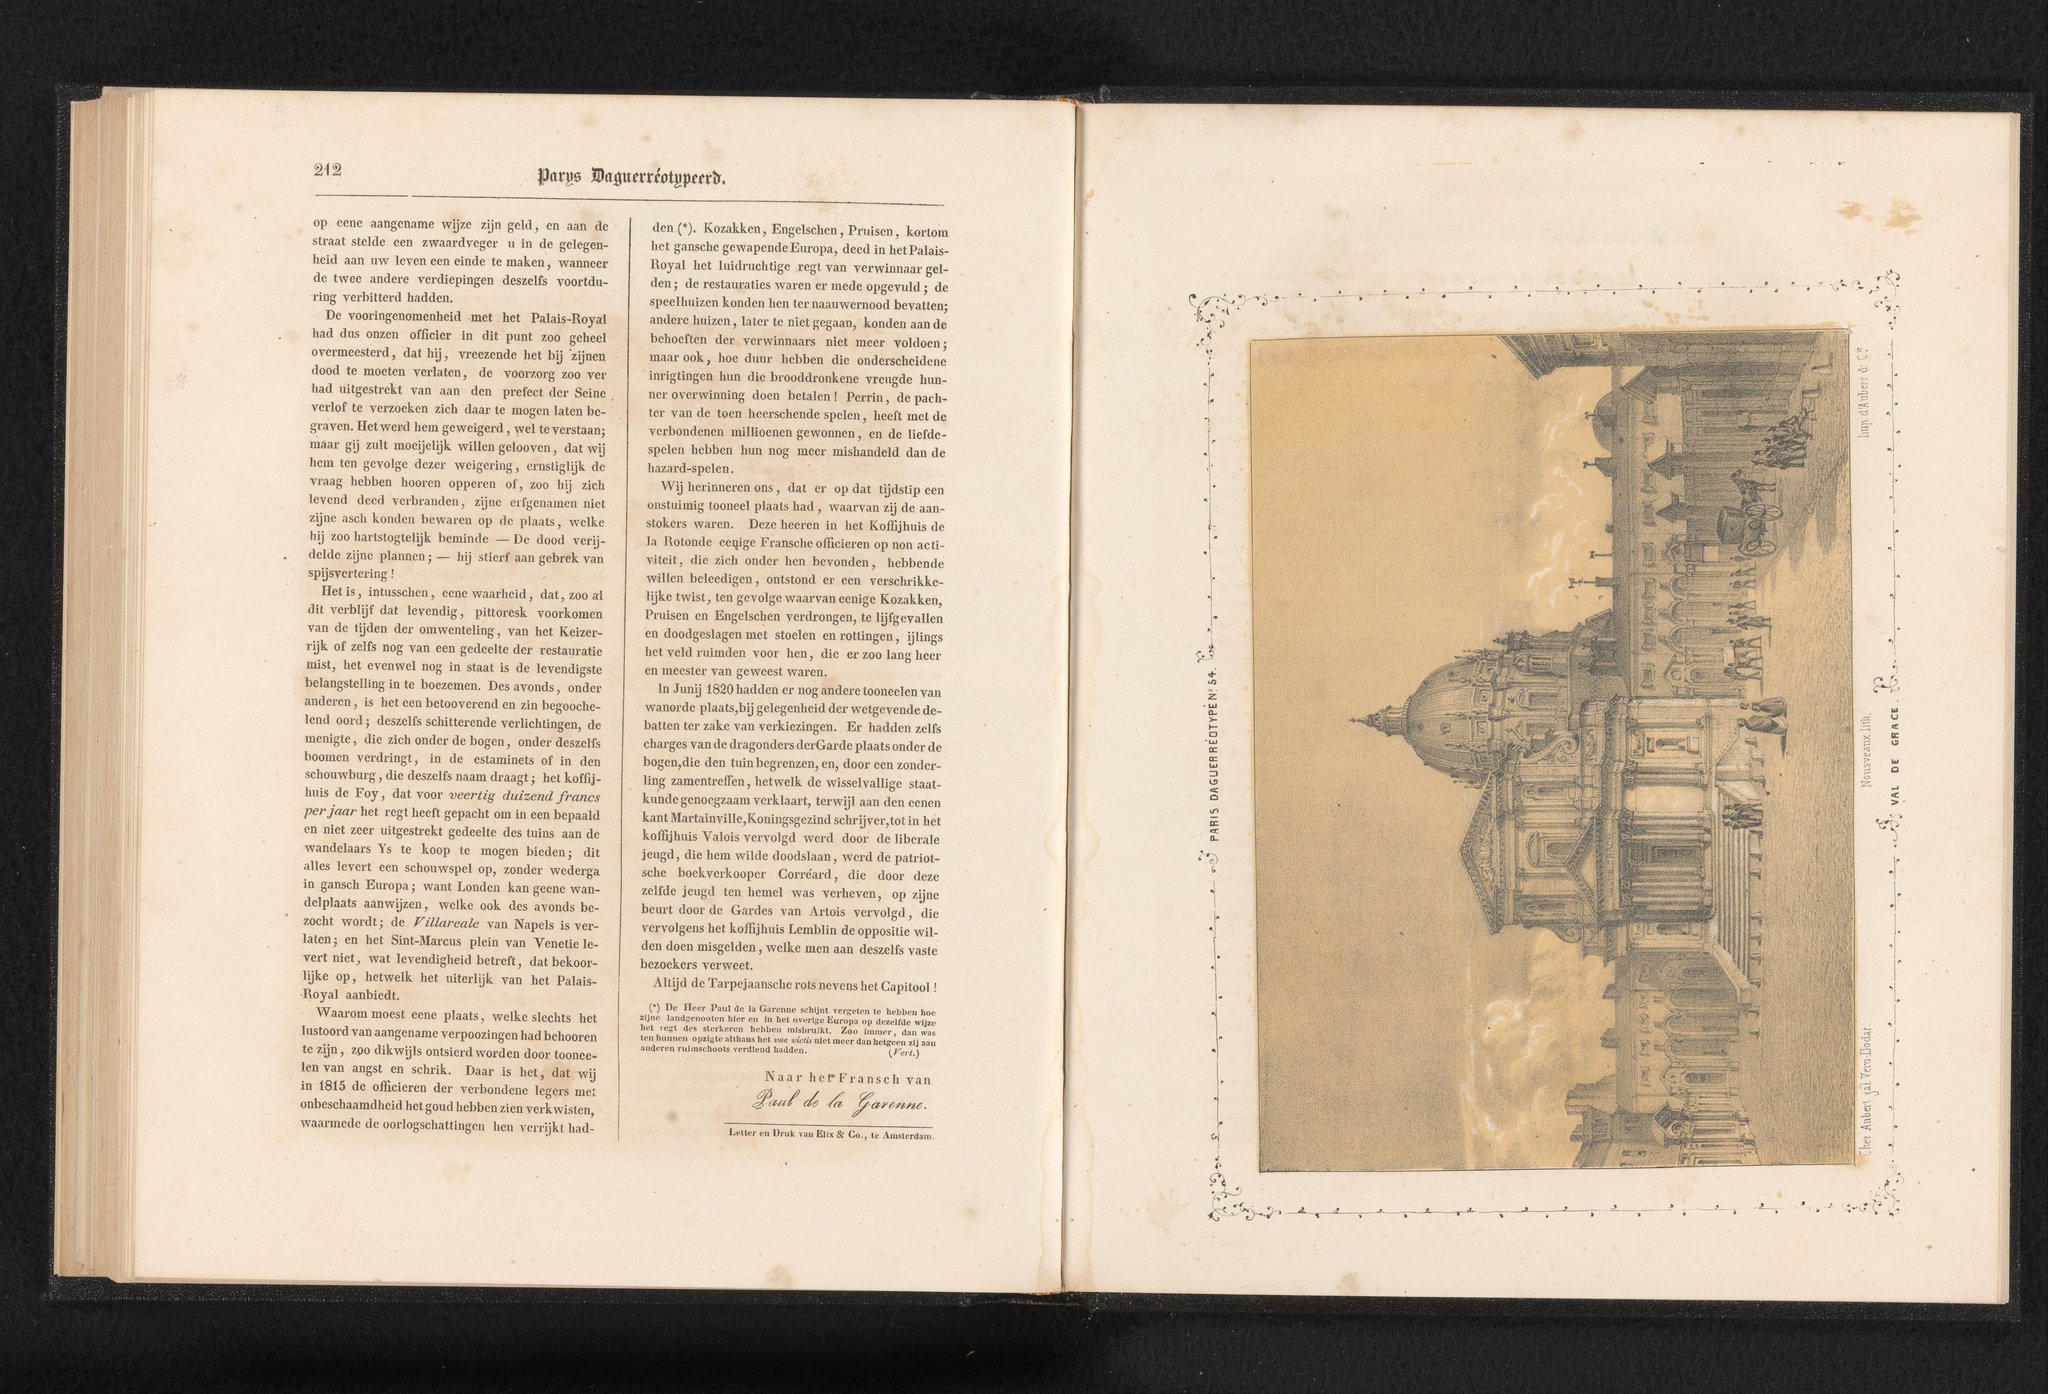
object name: print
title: Val de Grace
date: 1839-1840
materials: paper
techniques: tone lithography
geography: paris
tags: church (exterior)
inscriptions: inscription: ‘PARIS DAGUERRÉOTYPÉ No. 54.’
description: Prent op tweehonderdvijftiende ongenummerde pagina.